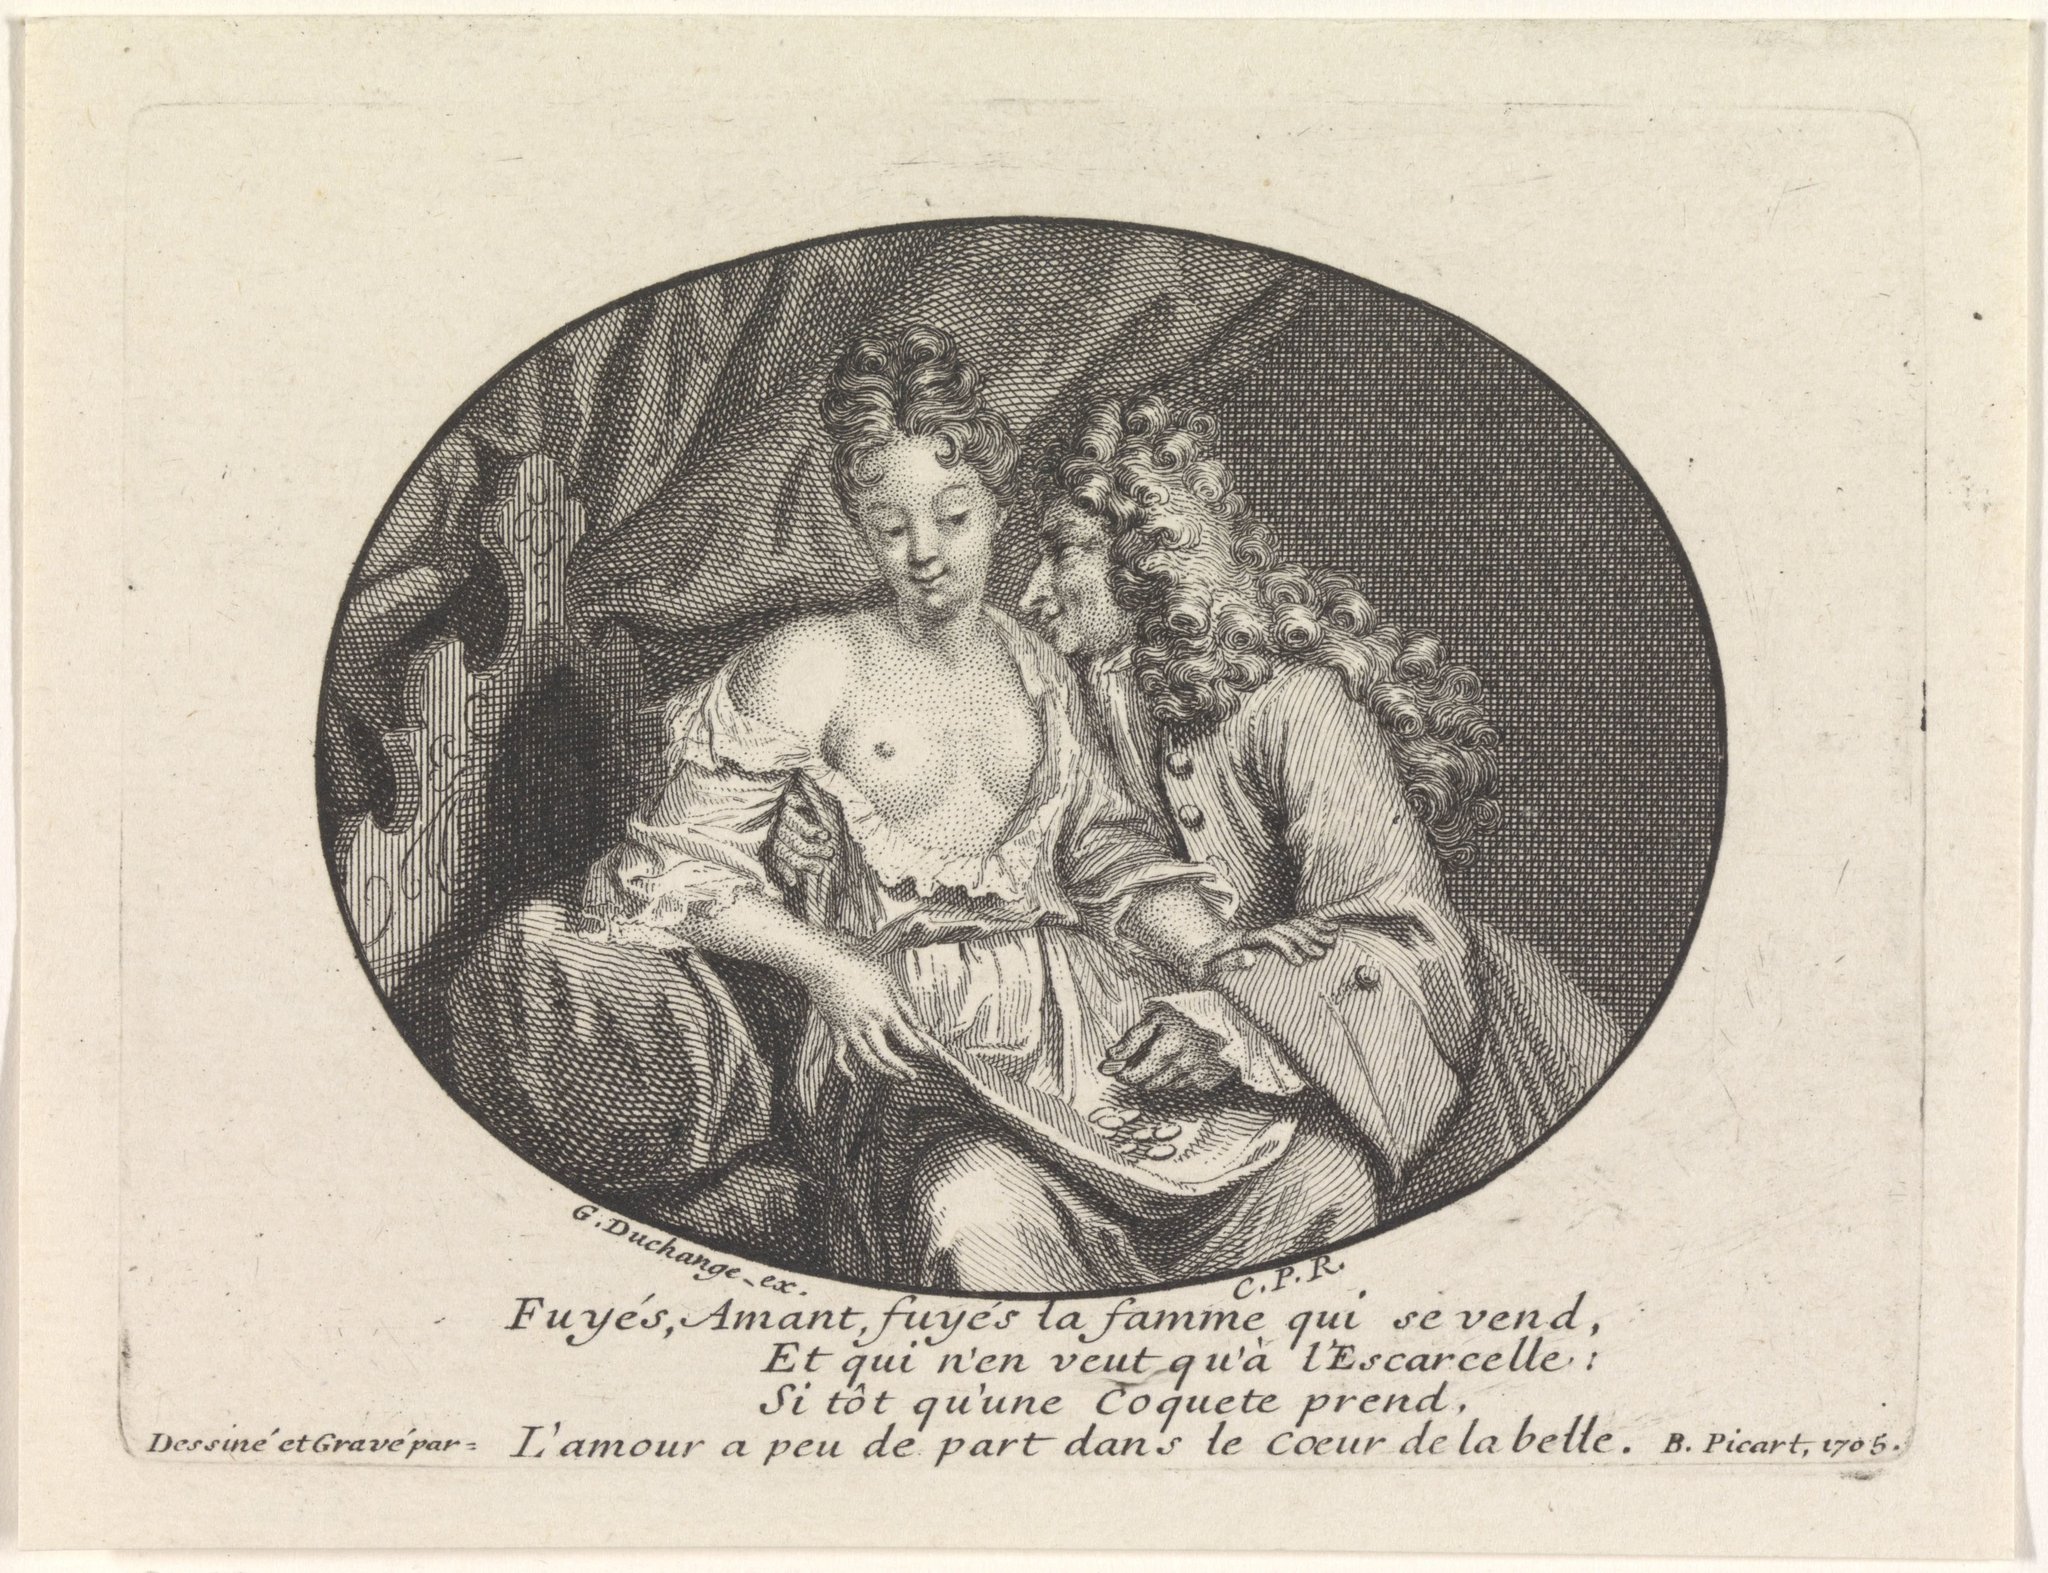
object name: print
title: Man Paying a Prostitute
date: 1705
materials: paper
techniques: engraving, etching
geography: paris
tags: whore, prostitute, lovers; courting, flirting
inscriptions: collector's mark: Lugt 2228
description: The man tosses coins in the prostitute’s lap, a symbol of unequal love. She brushes his hand aside. The caption cautions against paid love, which hardly involves the heart. Picart’s oeuvre is extensive. His prints were hugely popular and thus also frequently copied for commercial purposes, whether or not in reverse.